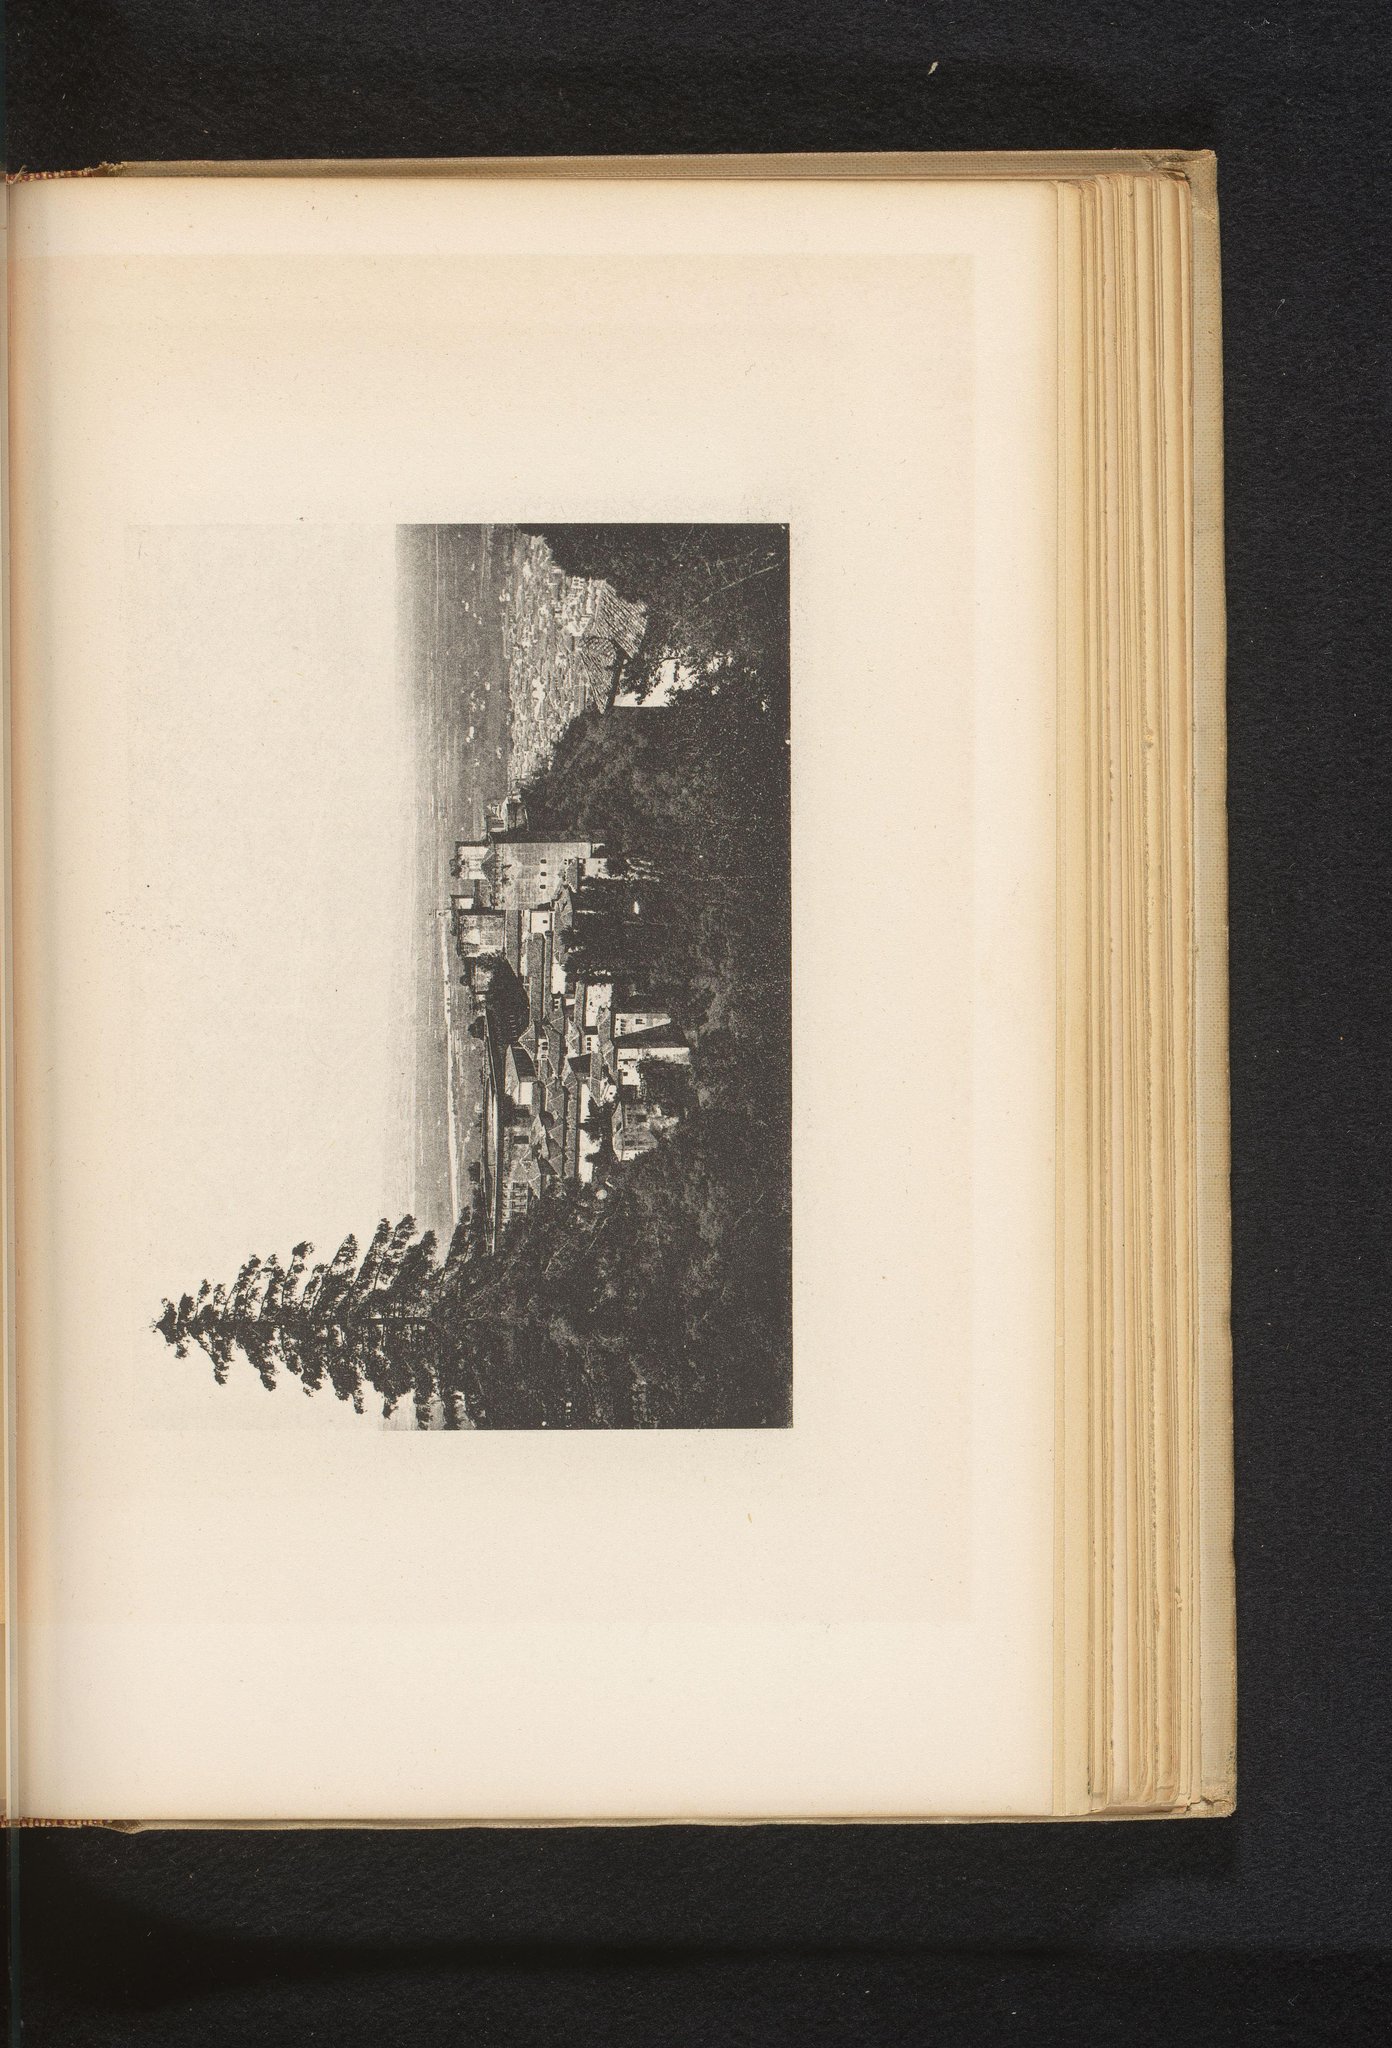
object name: page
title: Gezicht op het Alhambra en Granada, gezien vanaf de Generalife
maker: Anonymous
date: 1884-1894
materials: paper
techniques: photoaquatint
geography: granada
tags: city-view in general; 'veduta', palace